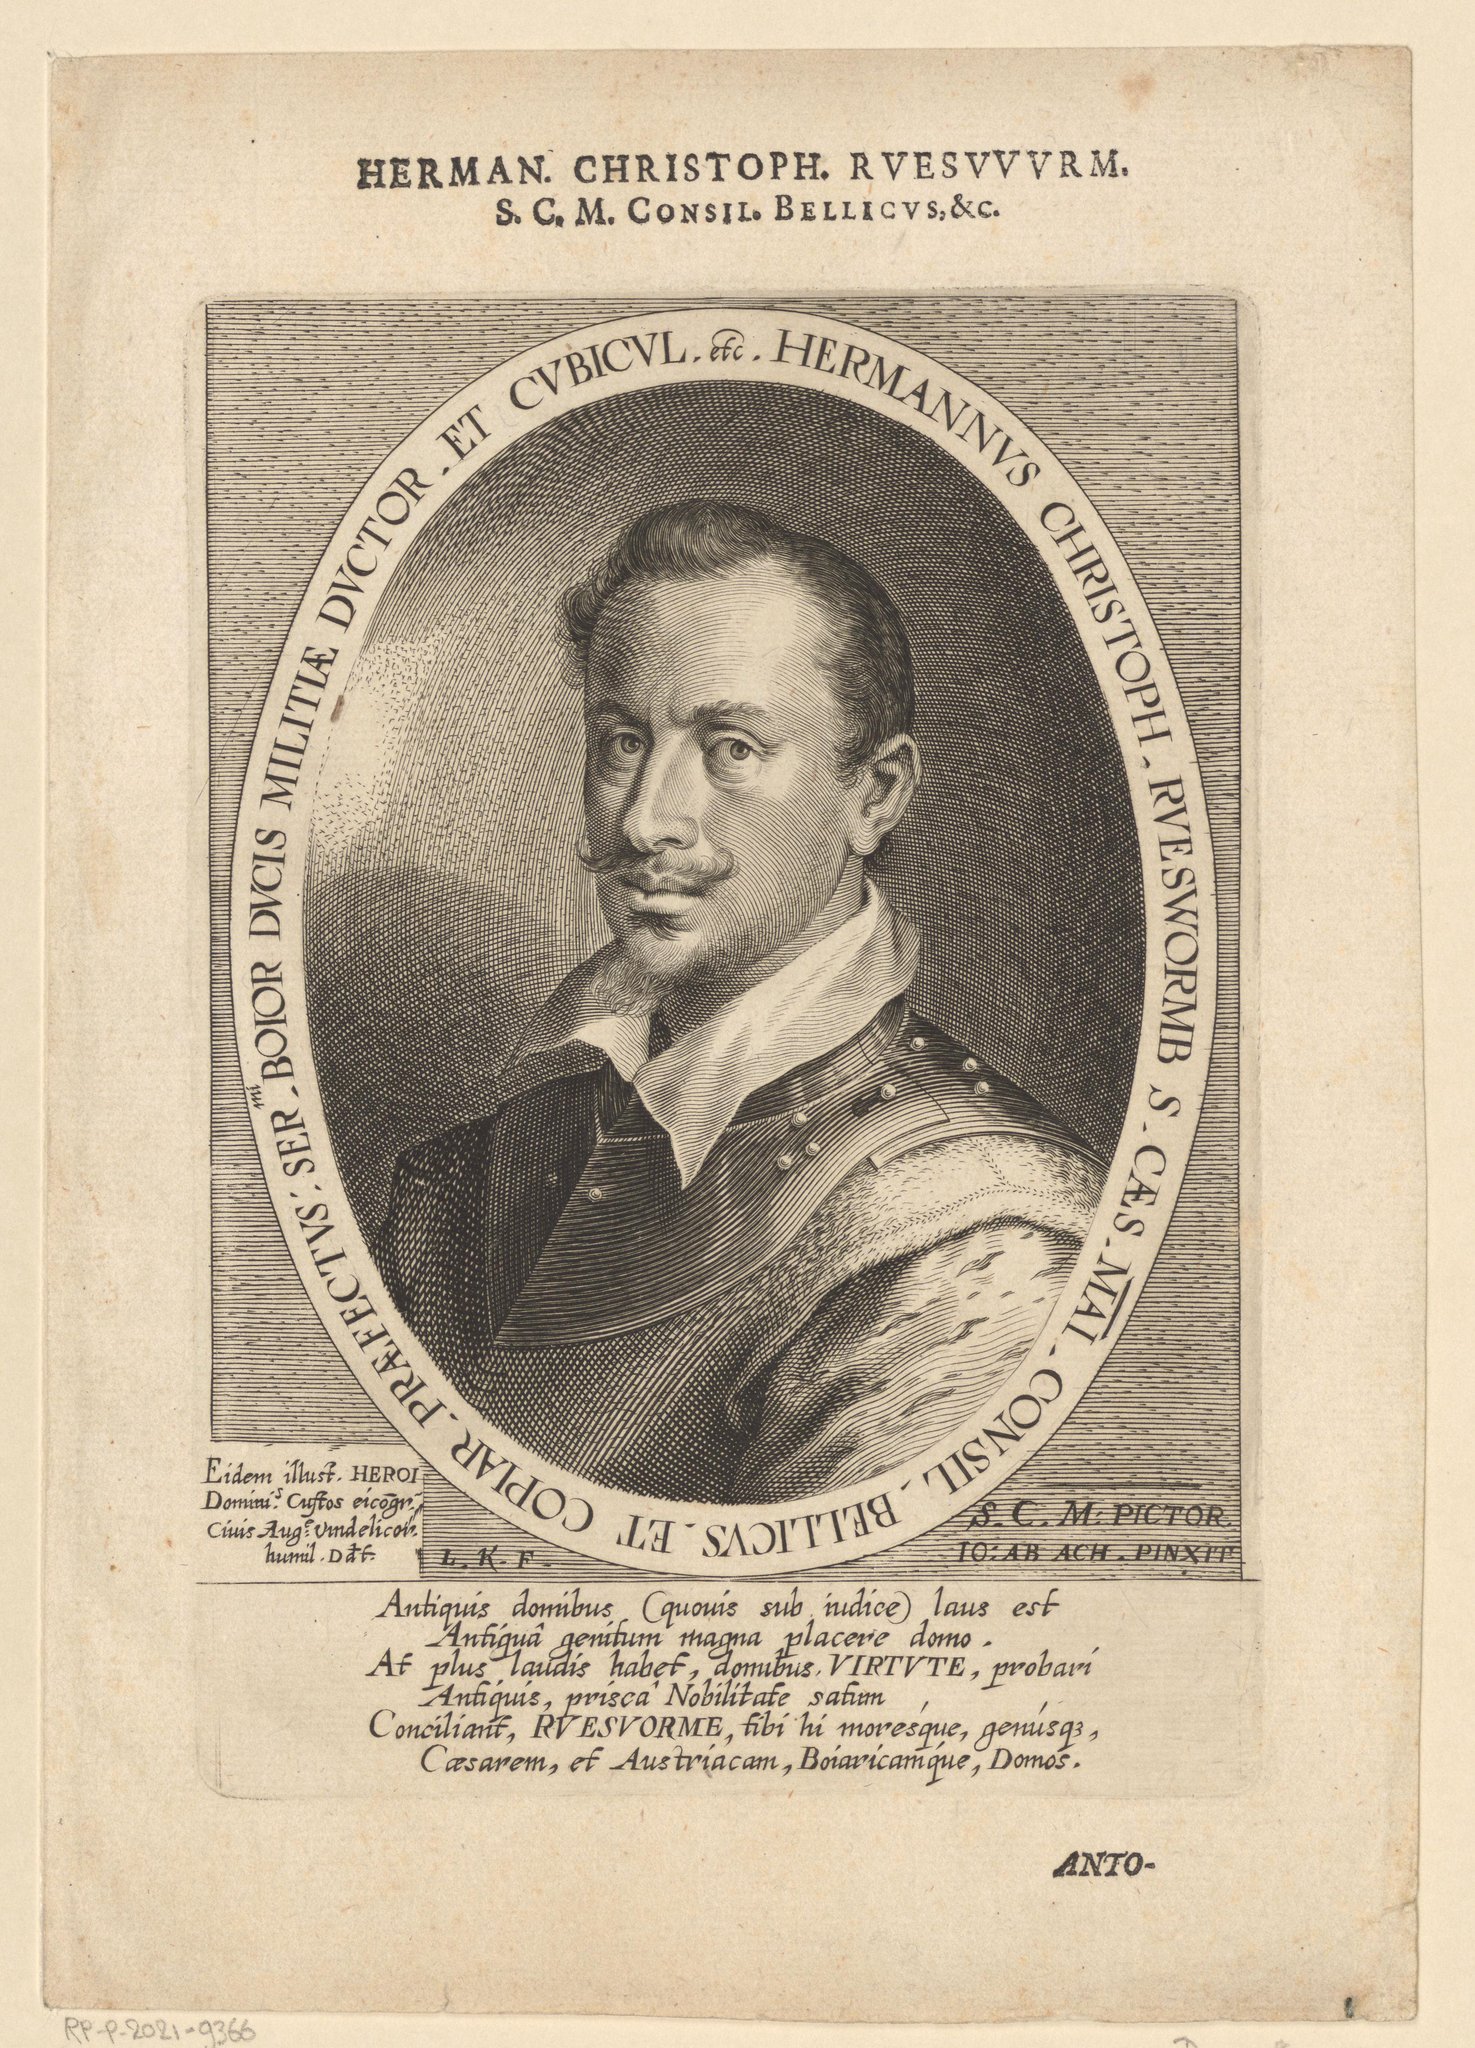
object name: book illustration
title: Atrium Heroicum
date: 1601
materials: paper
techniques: engraving, letterpress printing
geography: augsburg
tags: prague, earl, hermann christoph russworm, historical persons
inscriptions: watermark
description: Prent uit: Custos, Dominicus. Atrium heroicum Caesarum (...). Augsburg: Michael Manger, 1601, dl. 3.